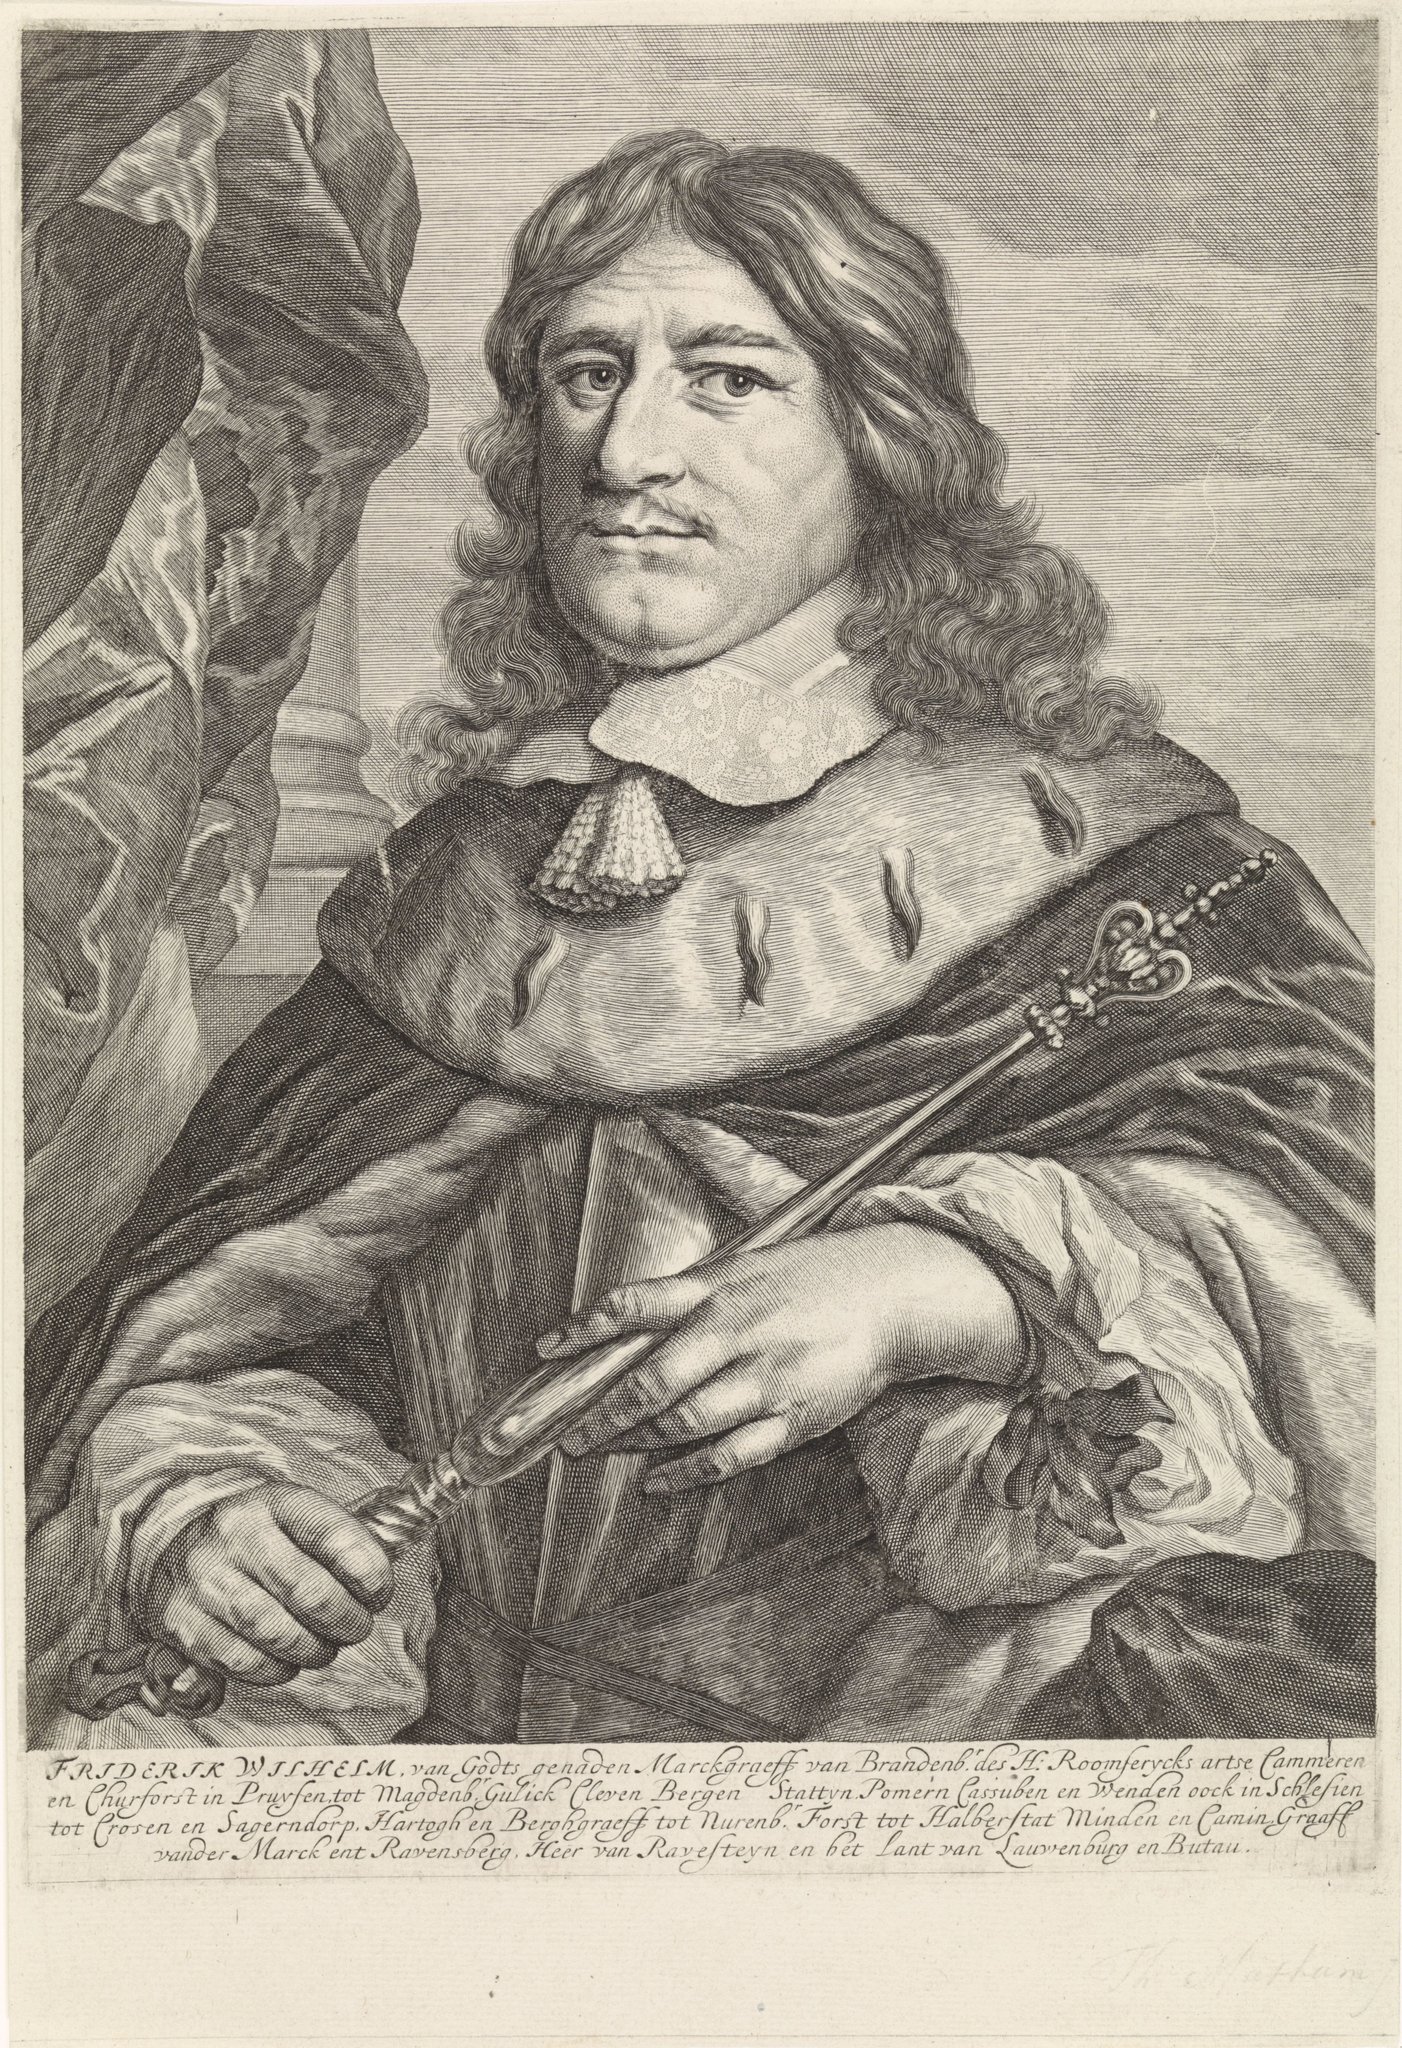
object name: print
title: Portret van Frederik Willem, keurvorst van Brandenburg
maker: theodor matham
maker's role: draughtsman, print maker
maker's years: 1605-1676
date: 1616-1676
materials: paper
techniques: engraving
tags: berlin, frederik willem van brandenburg (i), sceptre, staff (symbol of sovereignty)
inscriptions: collector's mark: Lugt 2228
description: Portret van Frederik Willem, keurvorst van Brandenburg met in zijn hand een scepter.